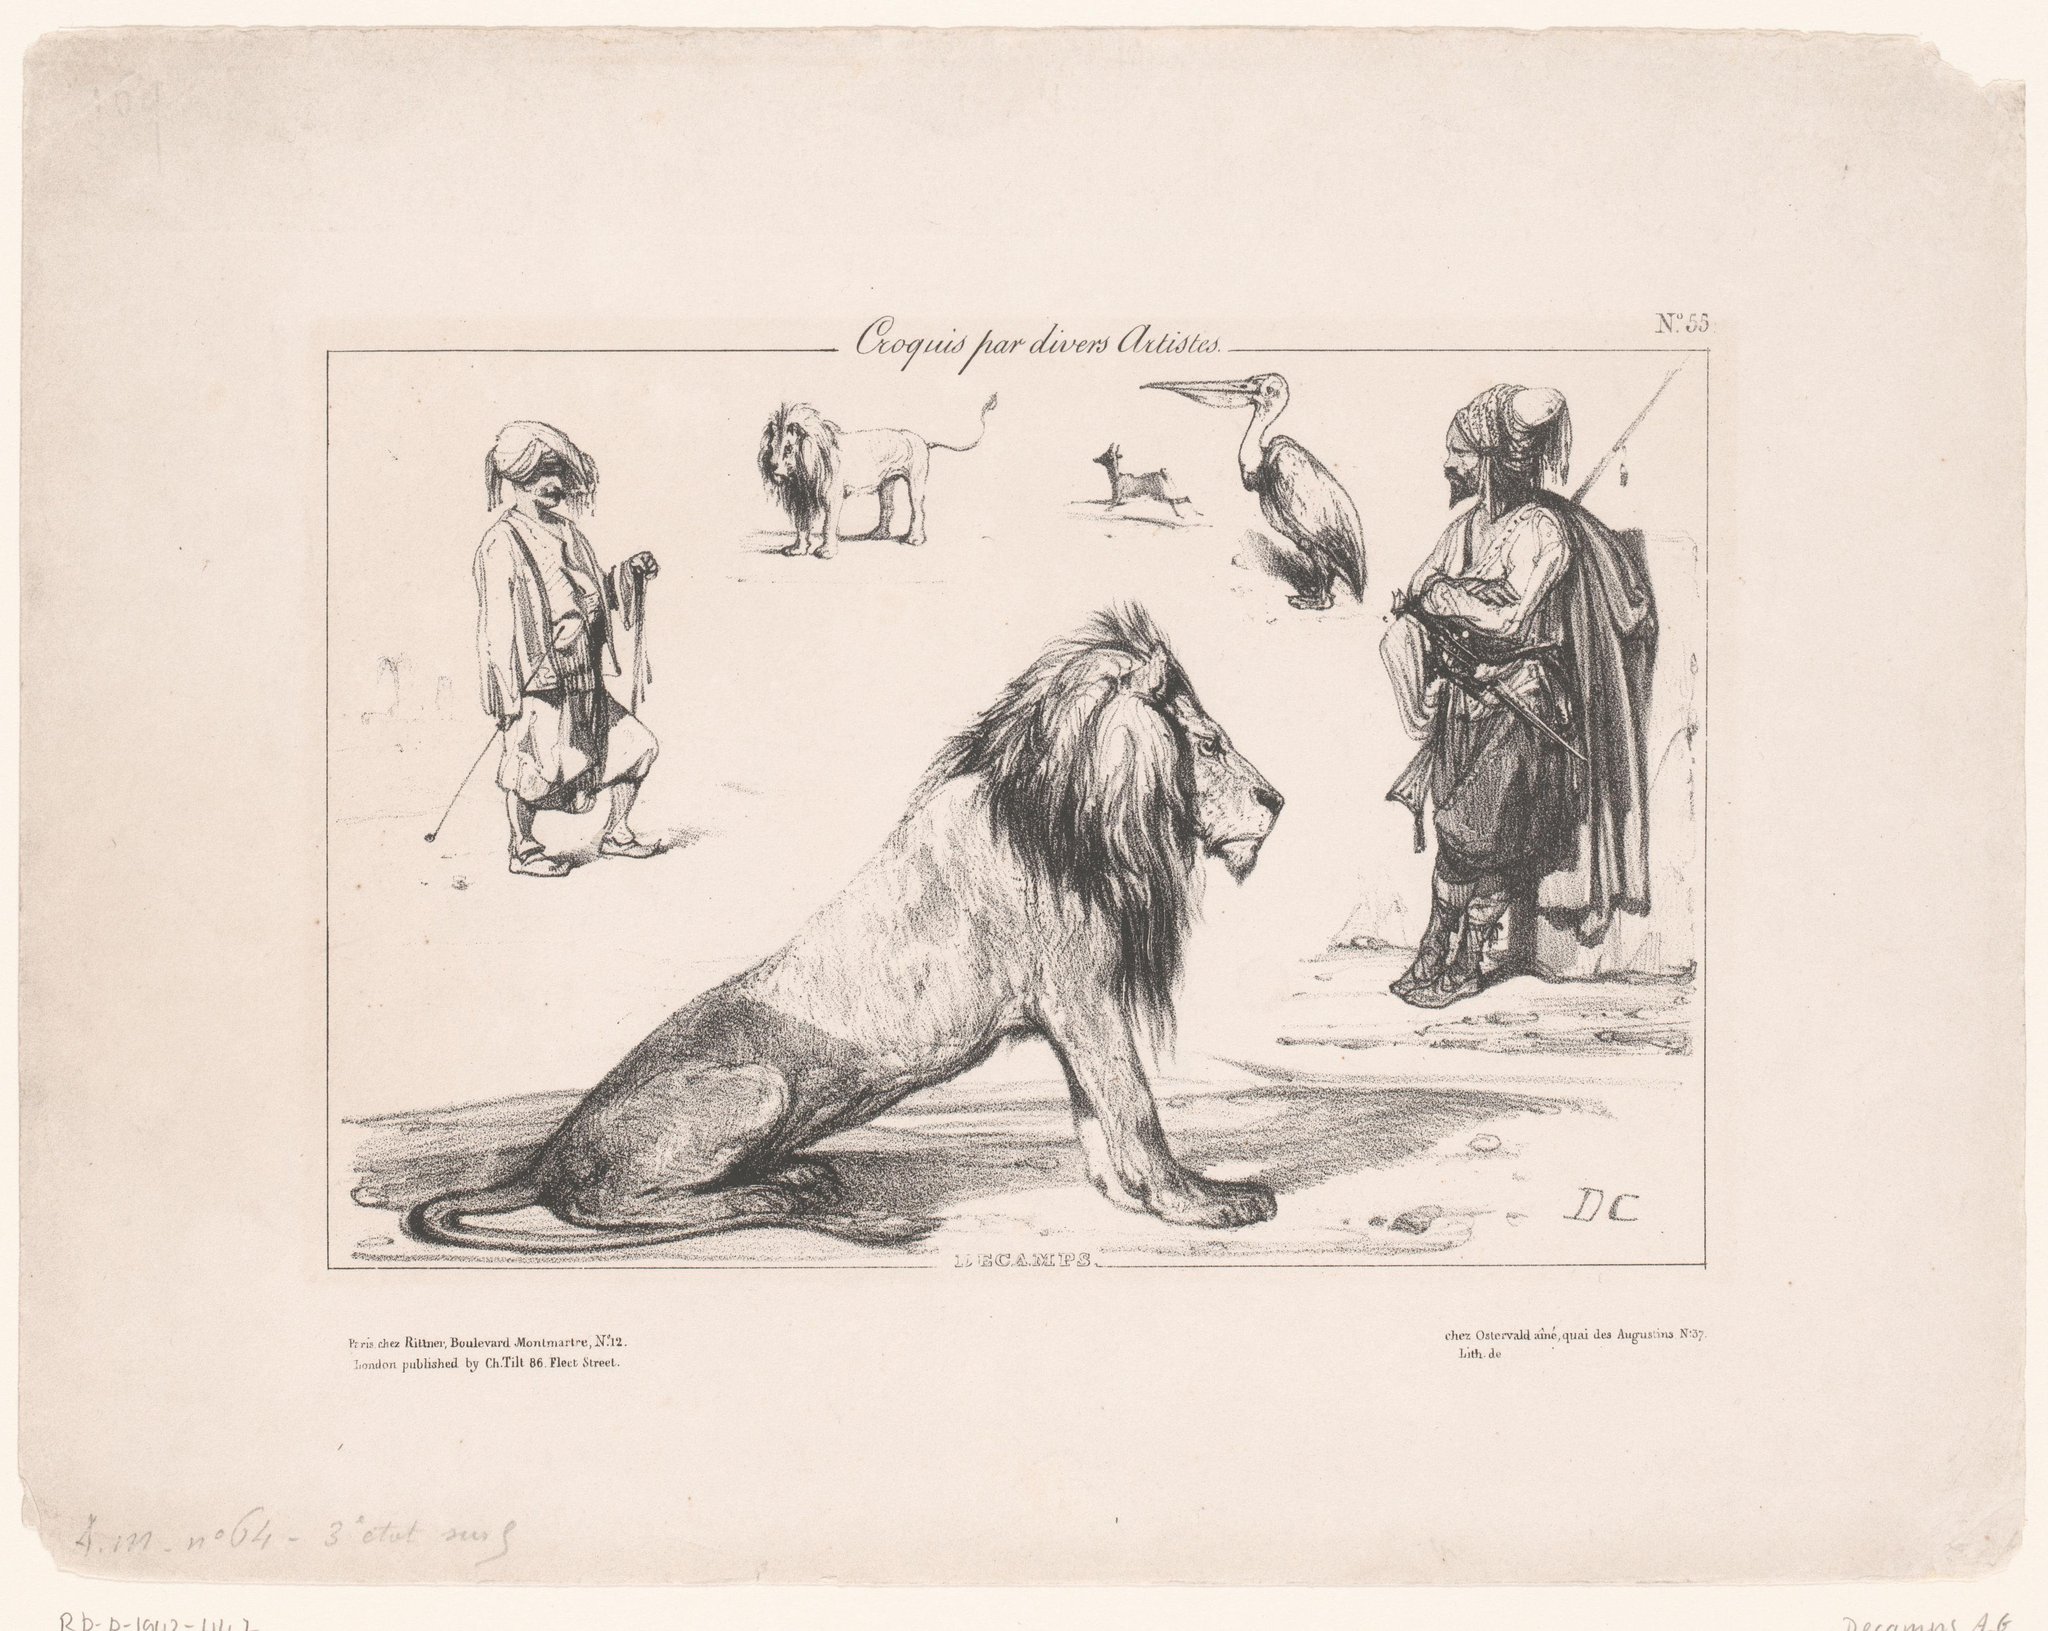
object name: print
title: Croquis par divers artistes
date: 1830-1831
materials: paper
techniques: lithograph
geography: paris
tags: head-gear: turban, beasts of prey, predatory animals: lion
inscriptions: collector's mark: Lugt 2228a, collector's mark: Lugt 2760